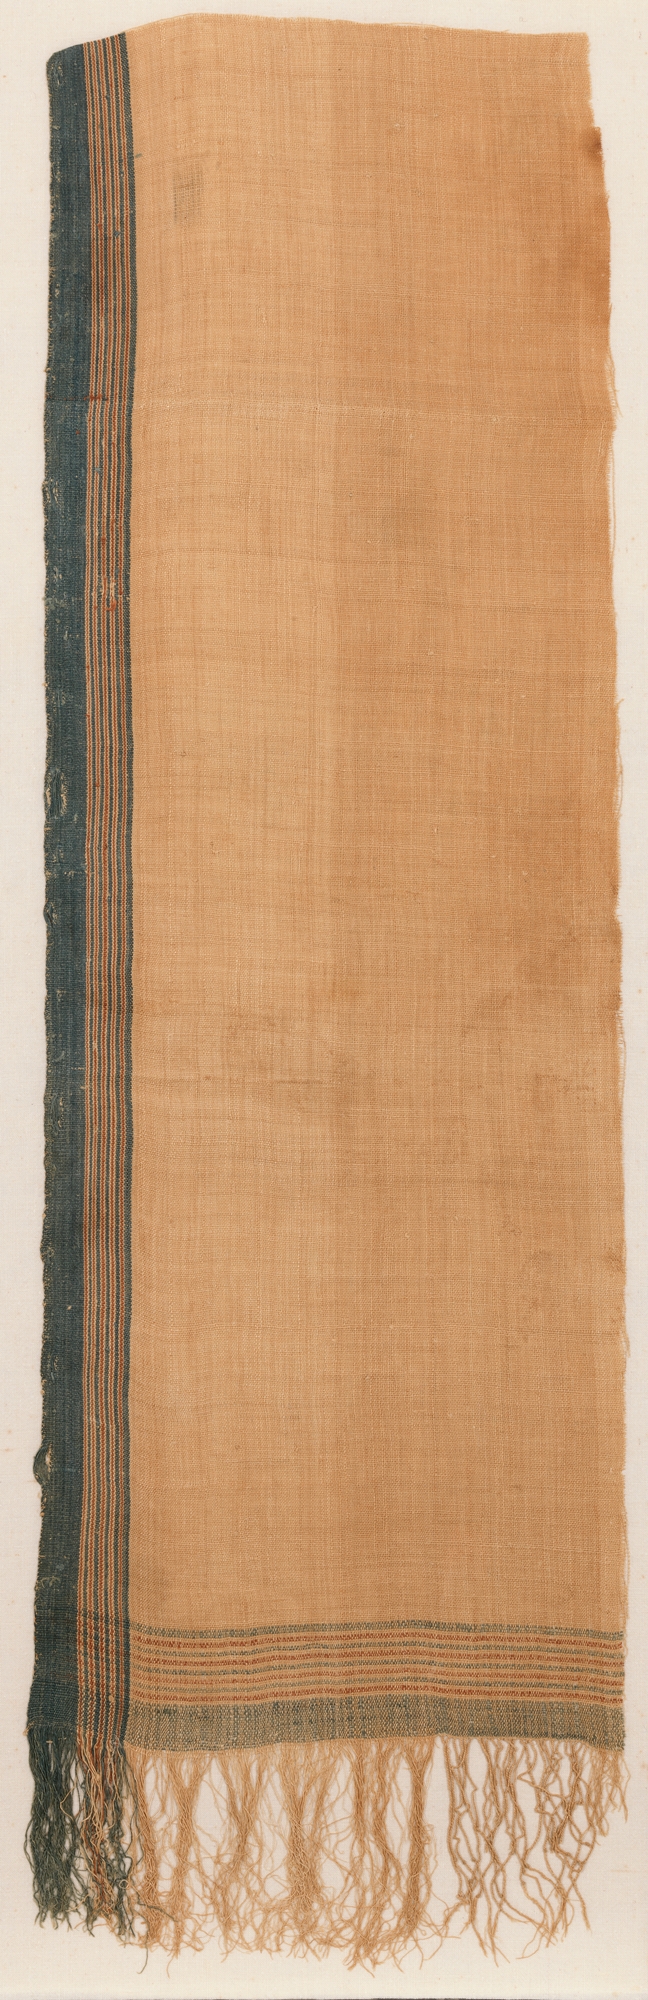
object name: mummy cloth fragment, djedptahefankh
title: Mummy Cloth Fragment of Djedptahefankh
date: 1070-945 BCE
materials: linen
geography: upper egypt, thebes